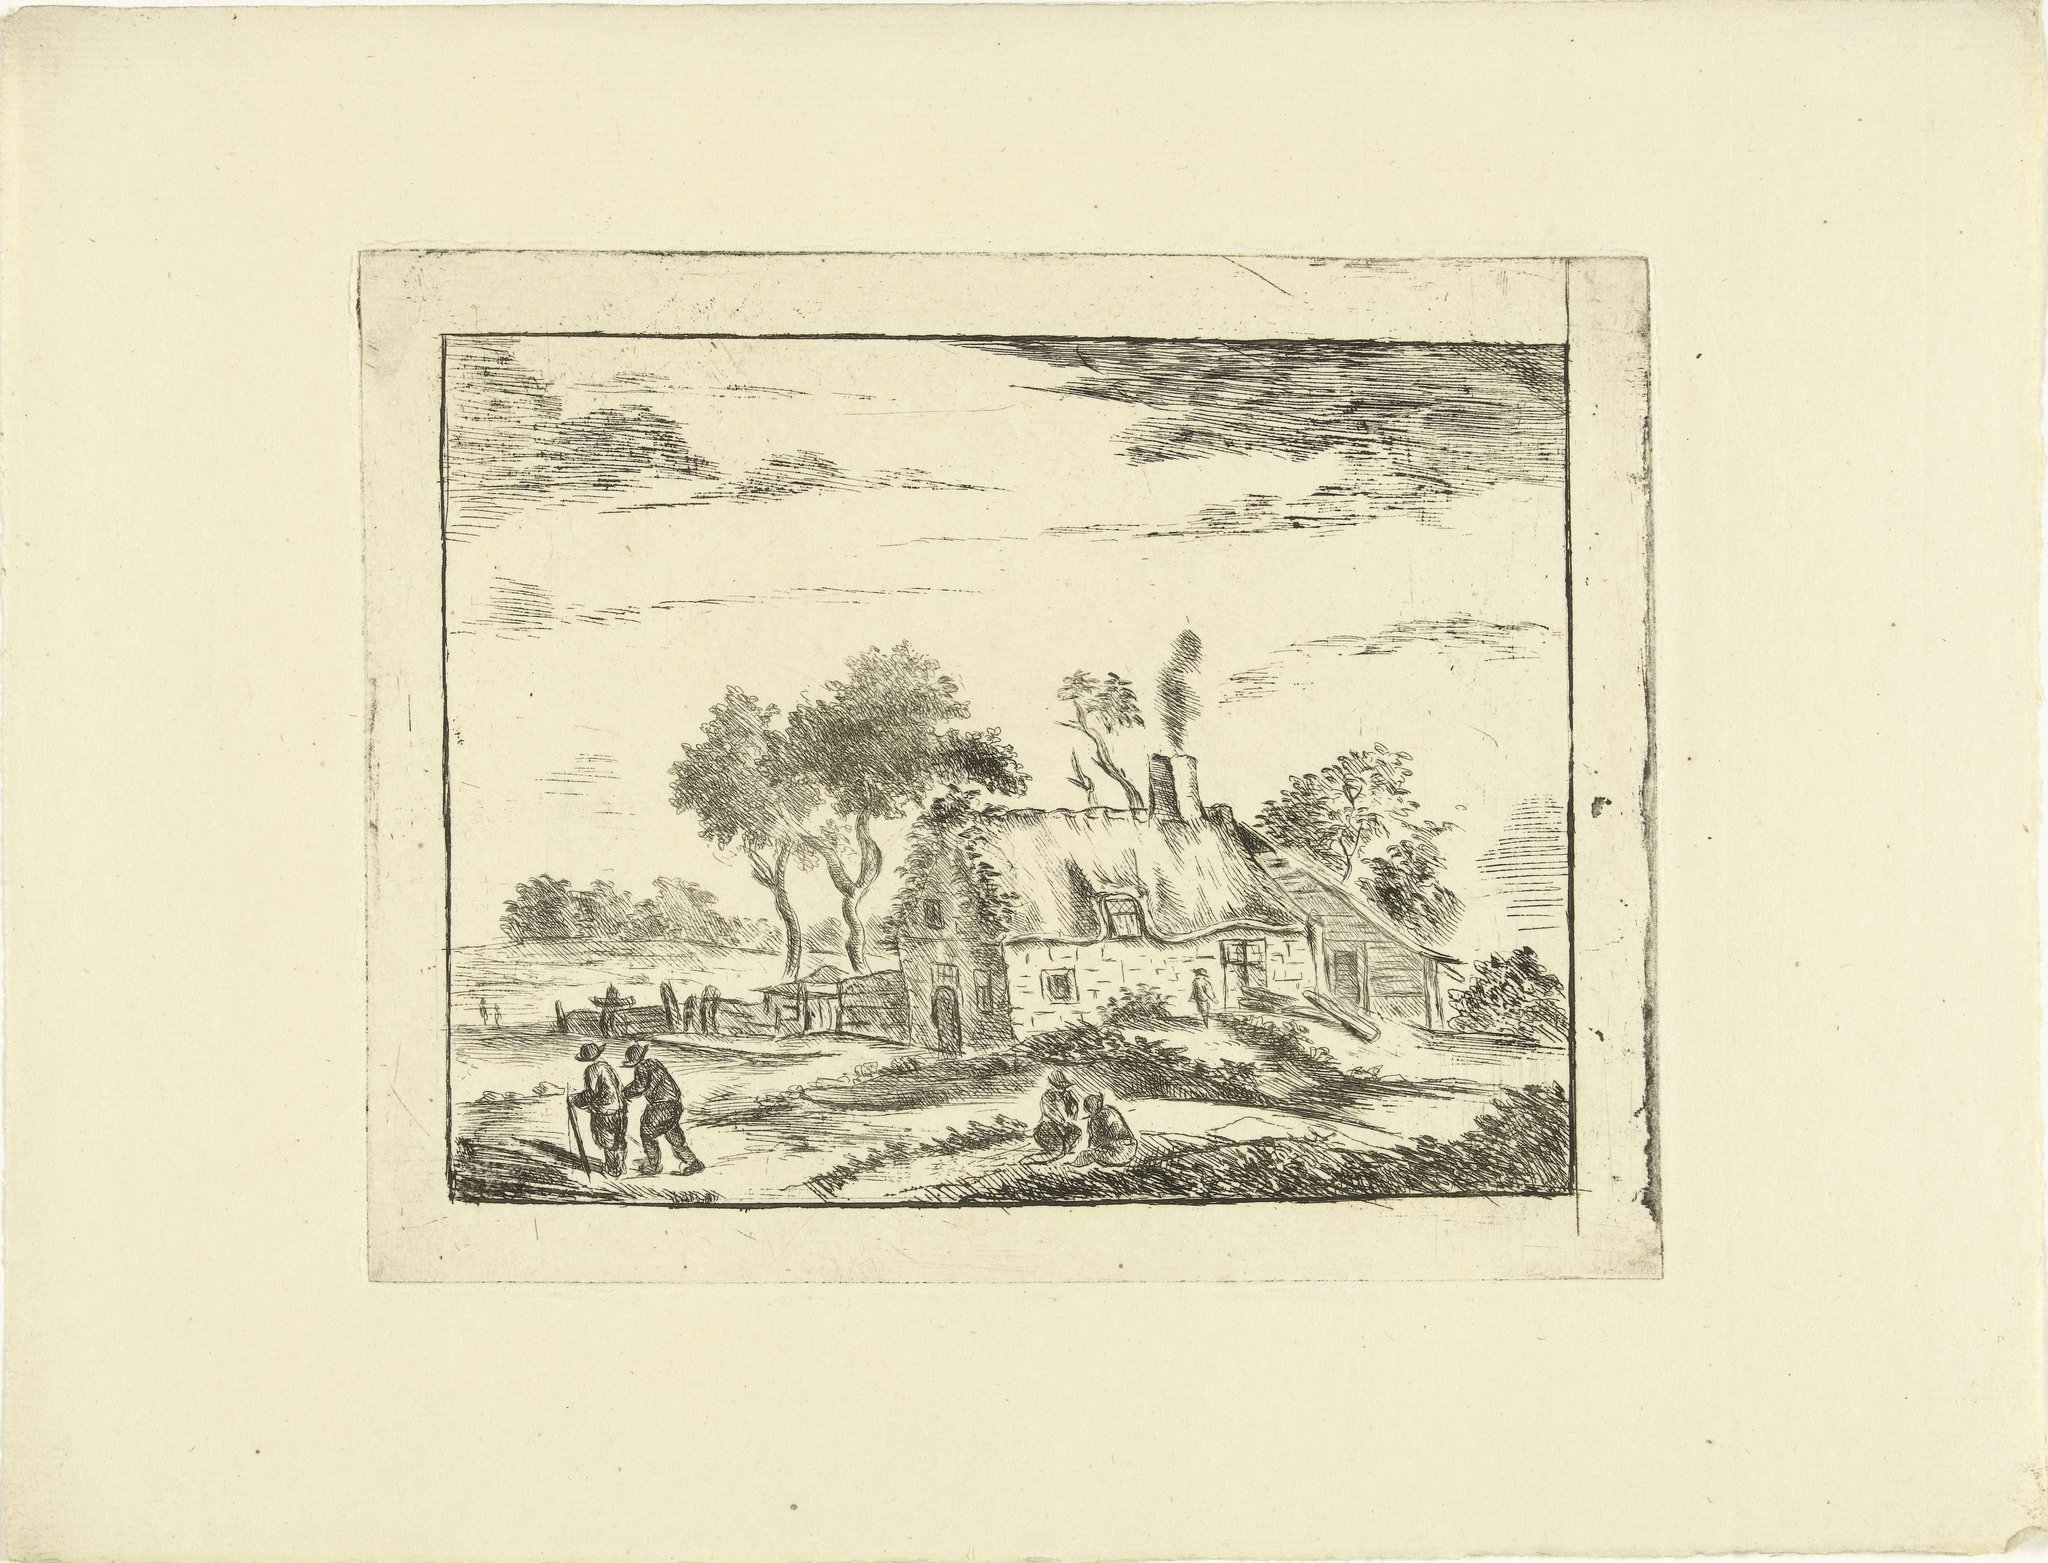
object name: print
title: Landschap met herberg en reizigers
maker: g. van citters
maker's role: print maker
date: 1750-1800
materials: paper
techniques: drypoint, etching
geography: netherlands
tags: landscapes in the temperate zone (+ landscape with figures, staffage), hotel, hostelry, inn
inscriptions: collector's mark: Lugt 2233